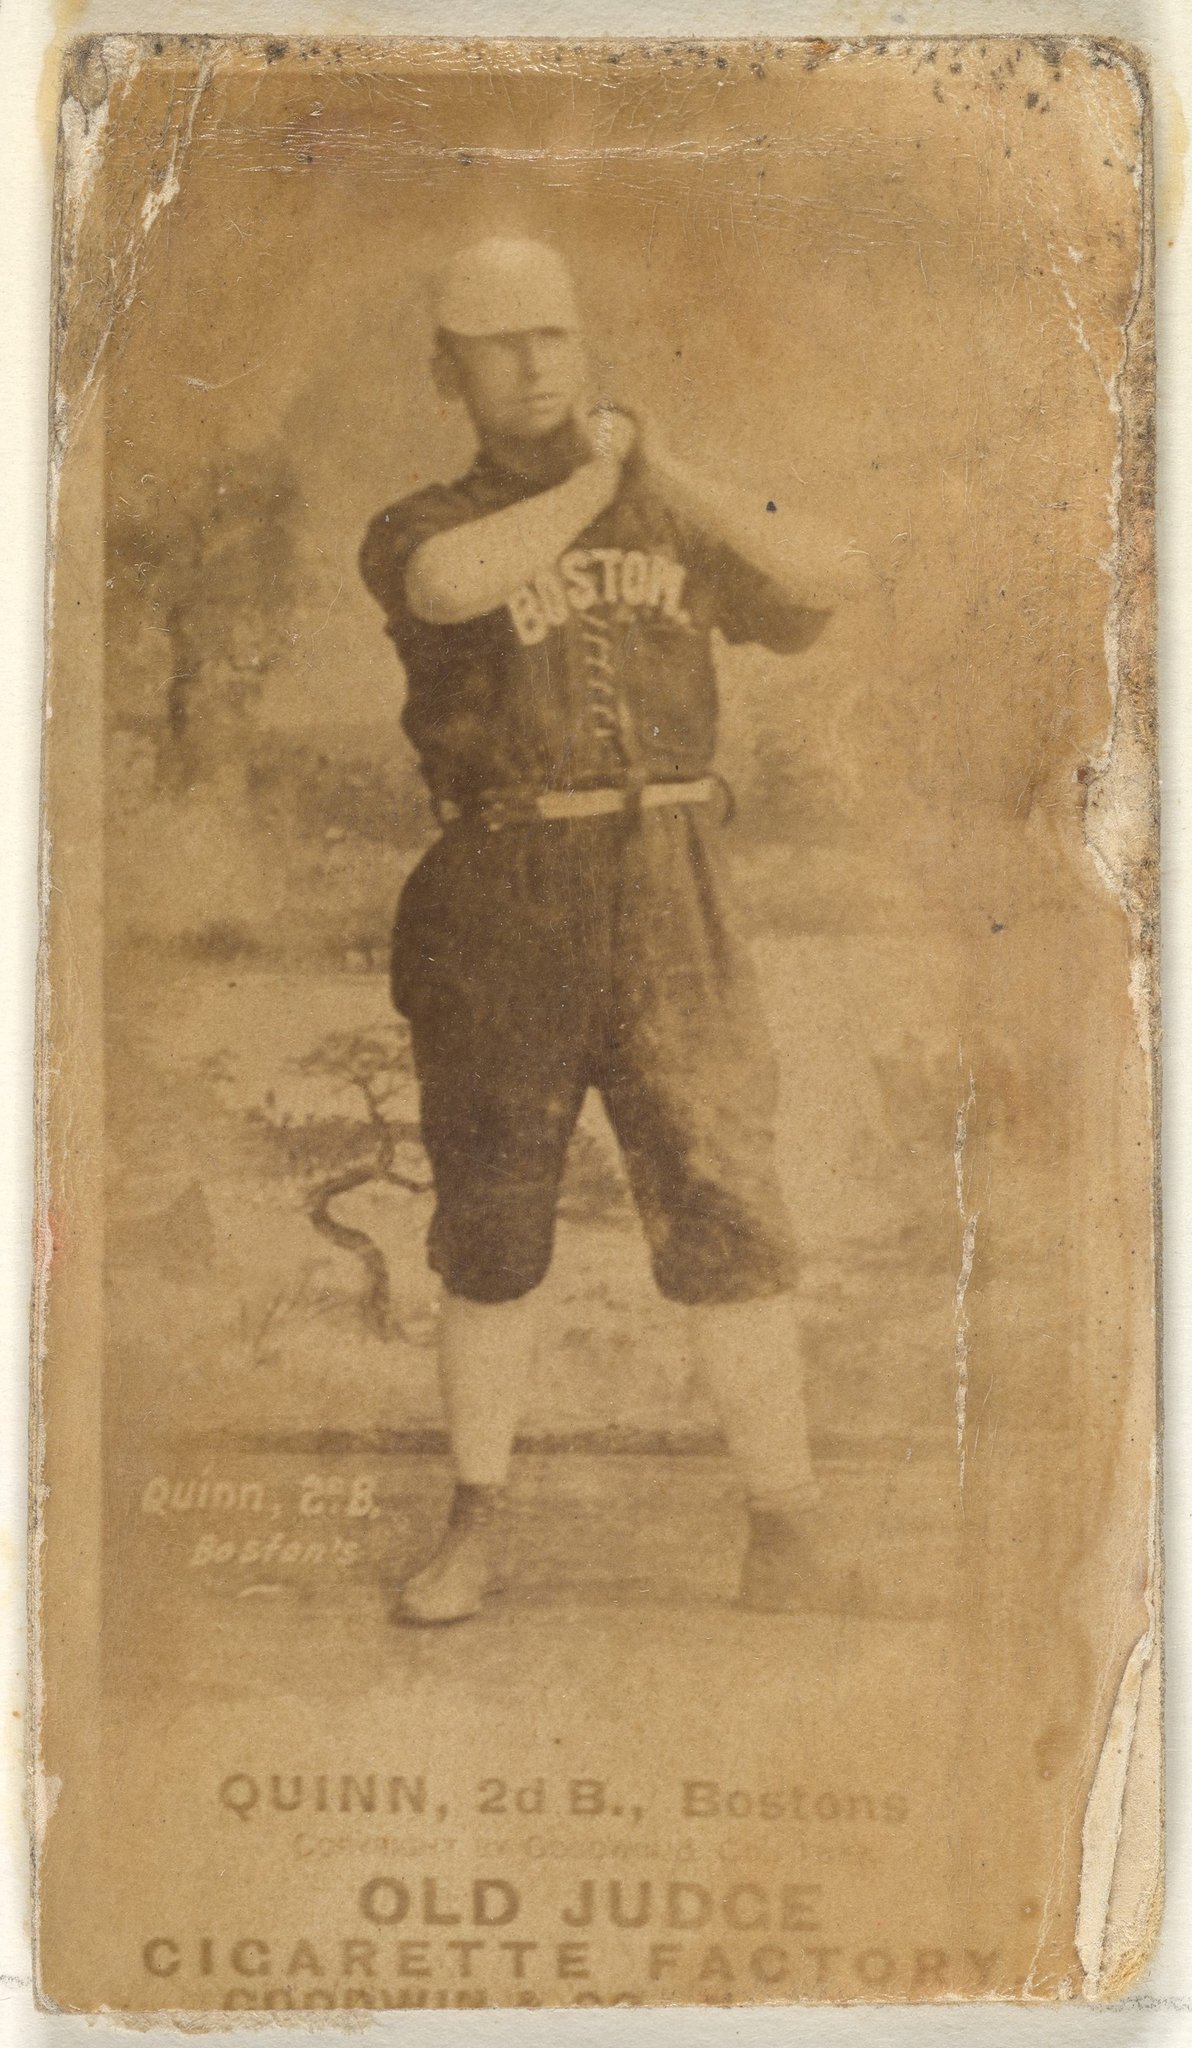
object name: baseball card, photograph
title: Quinn, 2nd Base, Boston, from the Old Judge series (N172) for Old Judge Cigarettes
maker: goodwin & company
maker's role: publisher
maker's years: 1850-1950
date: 1887-1890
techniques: albumen silver print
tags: men,portraits,baseball,athletes